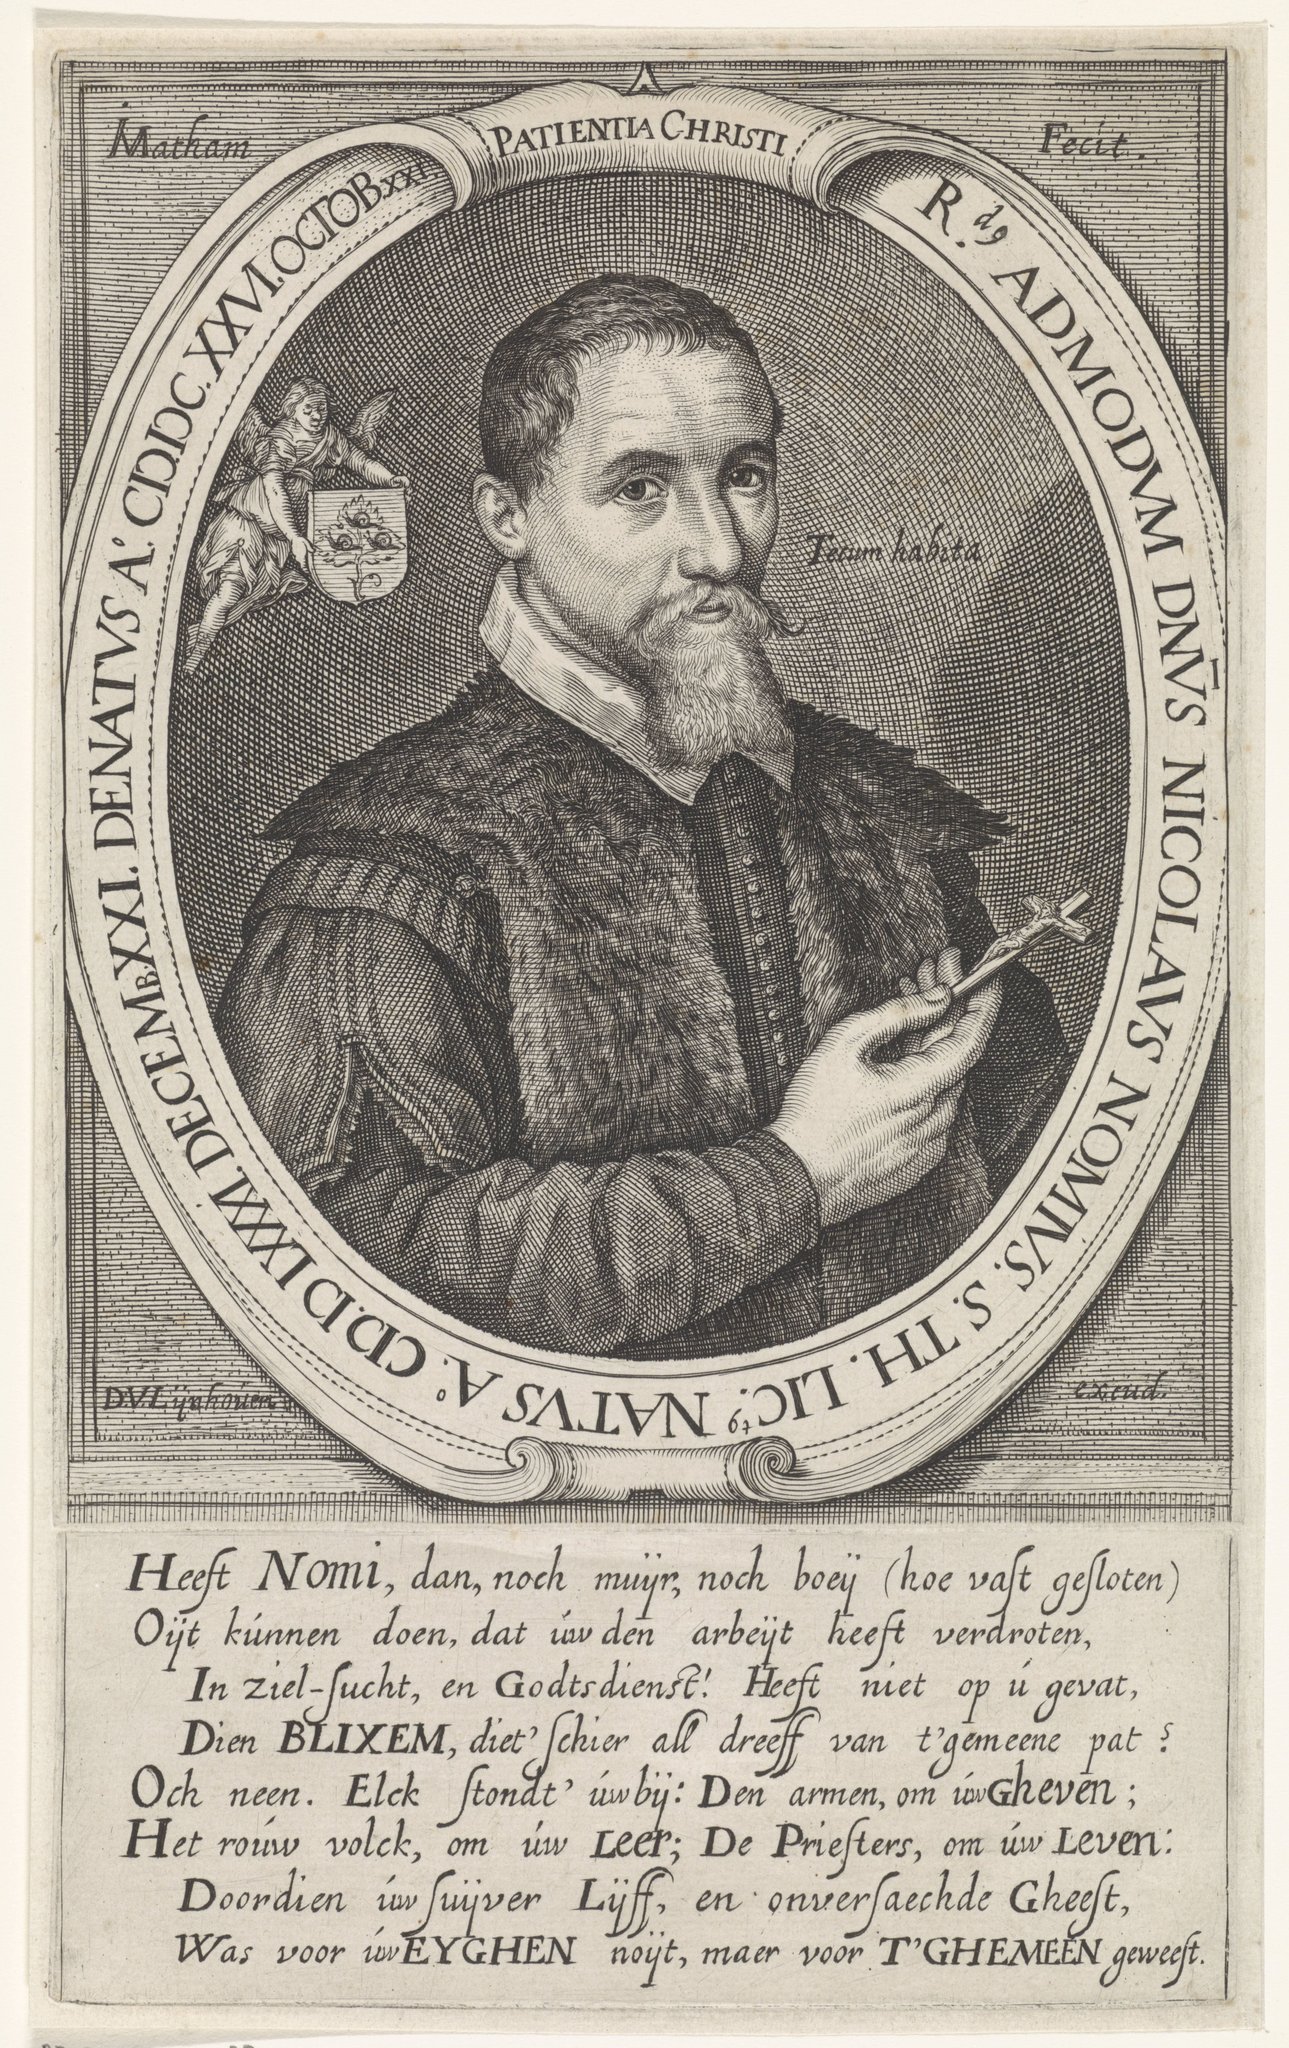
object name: print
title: Portret van Nicolaas Nomius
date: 1624-1628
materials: paper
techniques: engraving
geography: haarlem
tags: historical persons, crucifix ~ personal devotion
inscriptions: collector's mark: Lugt 240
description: Portret van de Haarlemse theoloog Nicolaas Nomius.